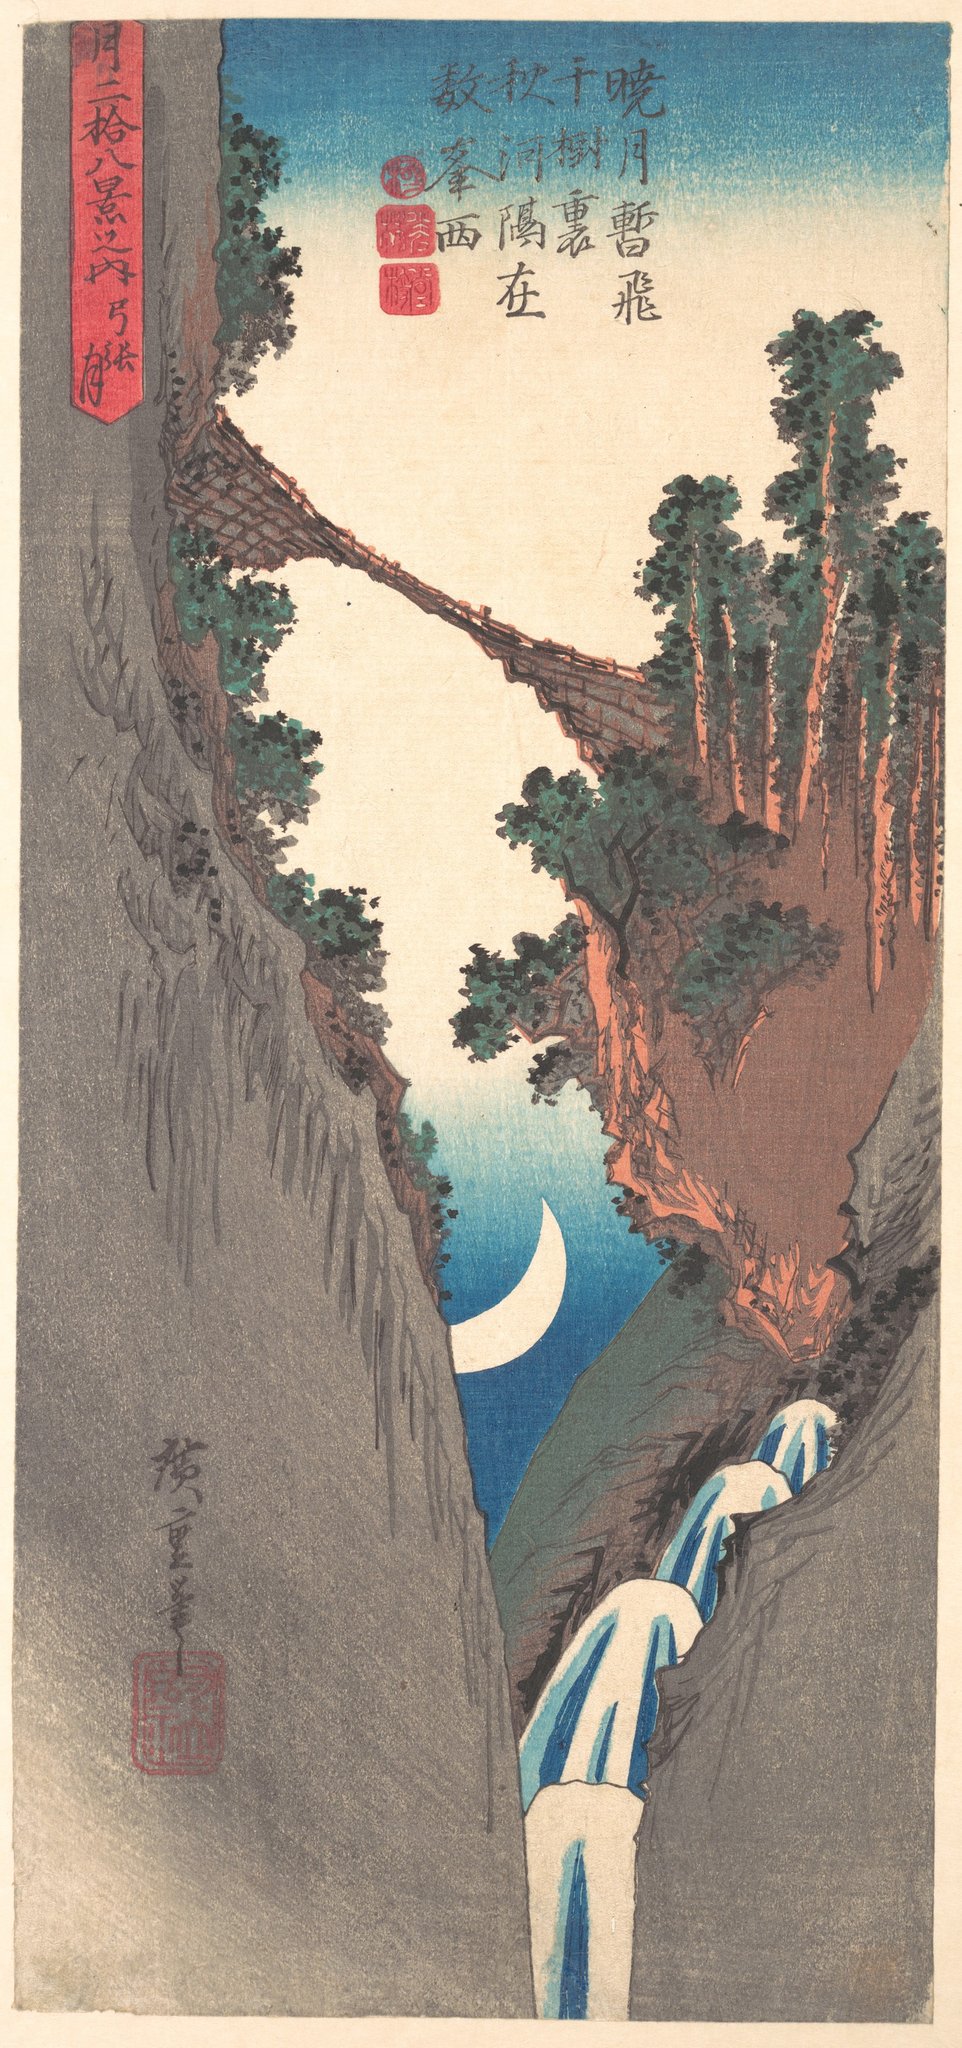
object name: print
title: Bow Moon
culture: japanese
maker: utagawa hiroshige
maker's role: artist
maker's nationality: japanese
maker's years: 1797-1858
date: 1832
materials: ink, paper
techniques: woodblock print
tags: waterfalls,moon,hills,trees